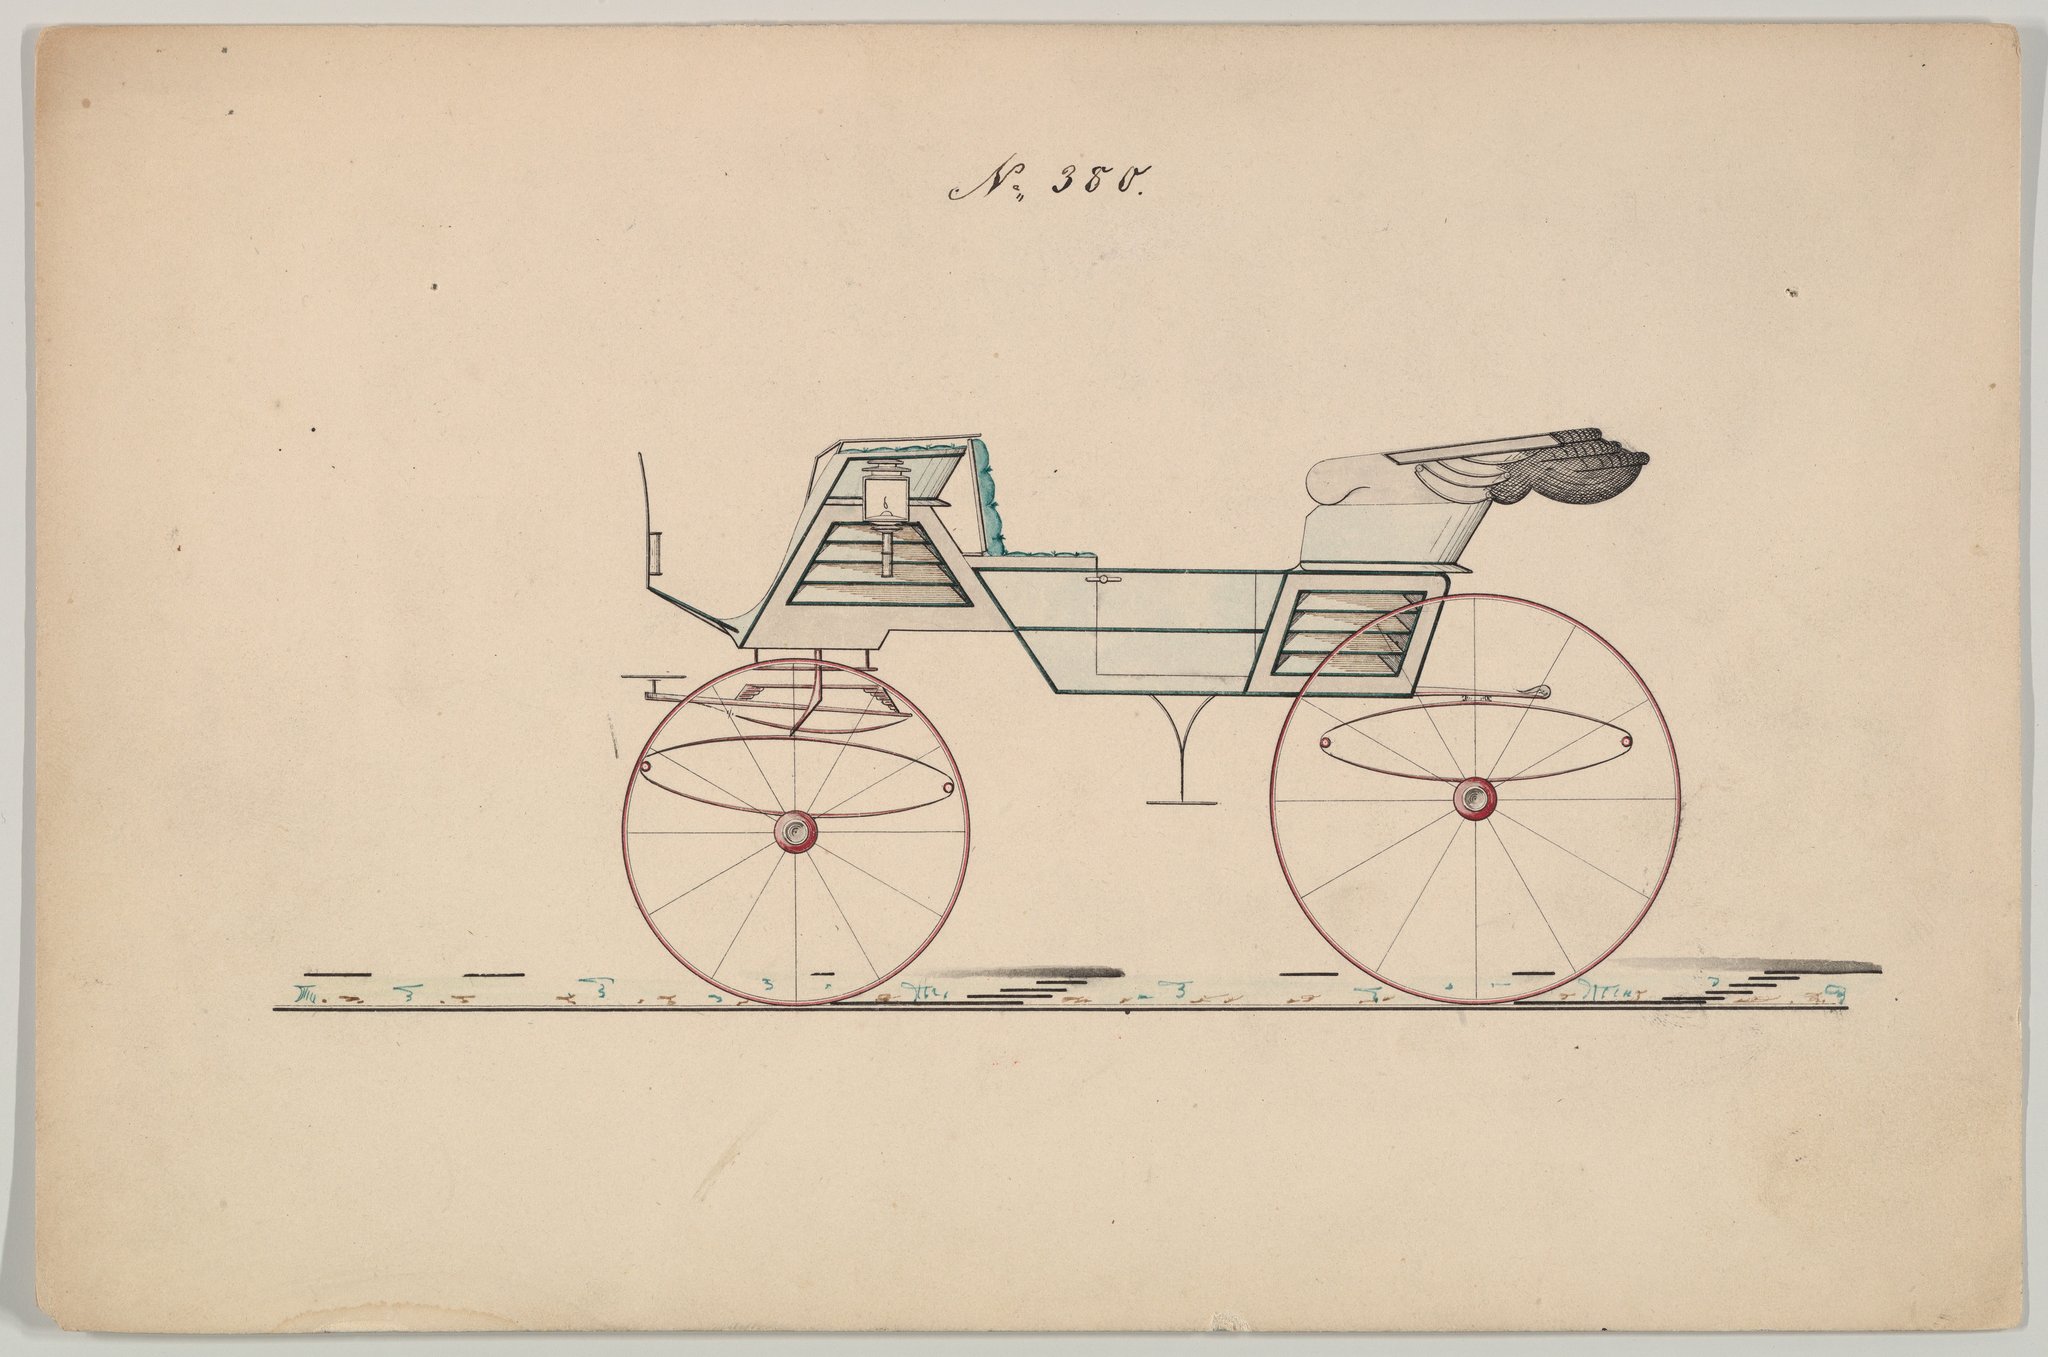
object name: drawing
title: Design for Vis-à-vis, no. 380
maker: brewster & co.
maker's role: manufacturer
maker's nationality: american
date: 1850-1870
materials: gouache, ink, watercolor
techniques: pen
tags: carriages